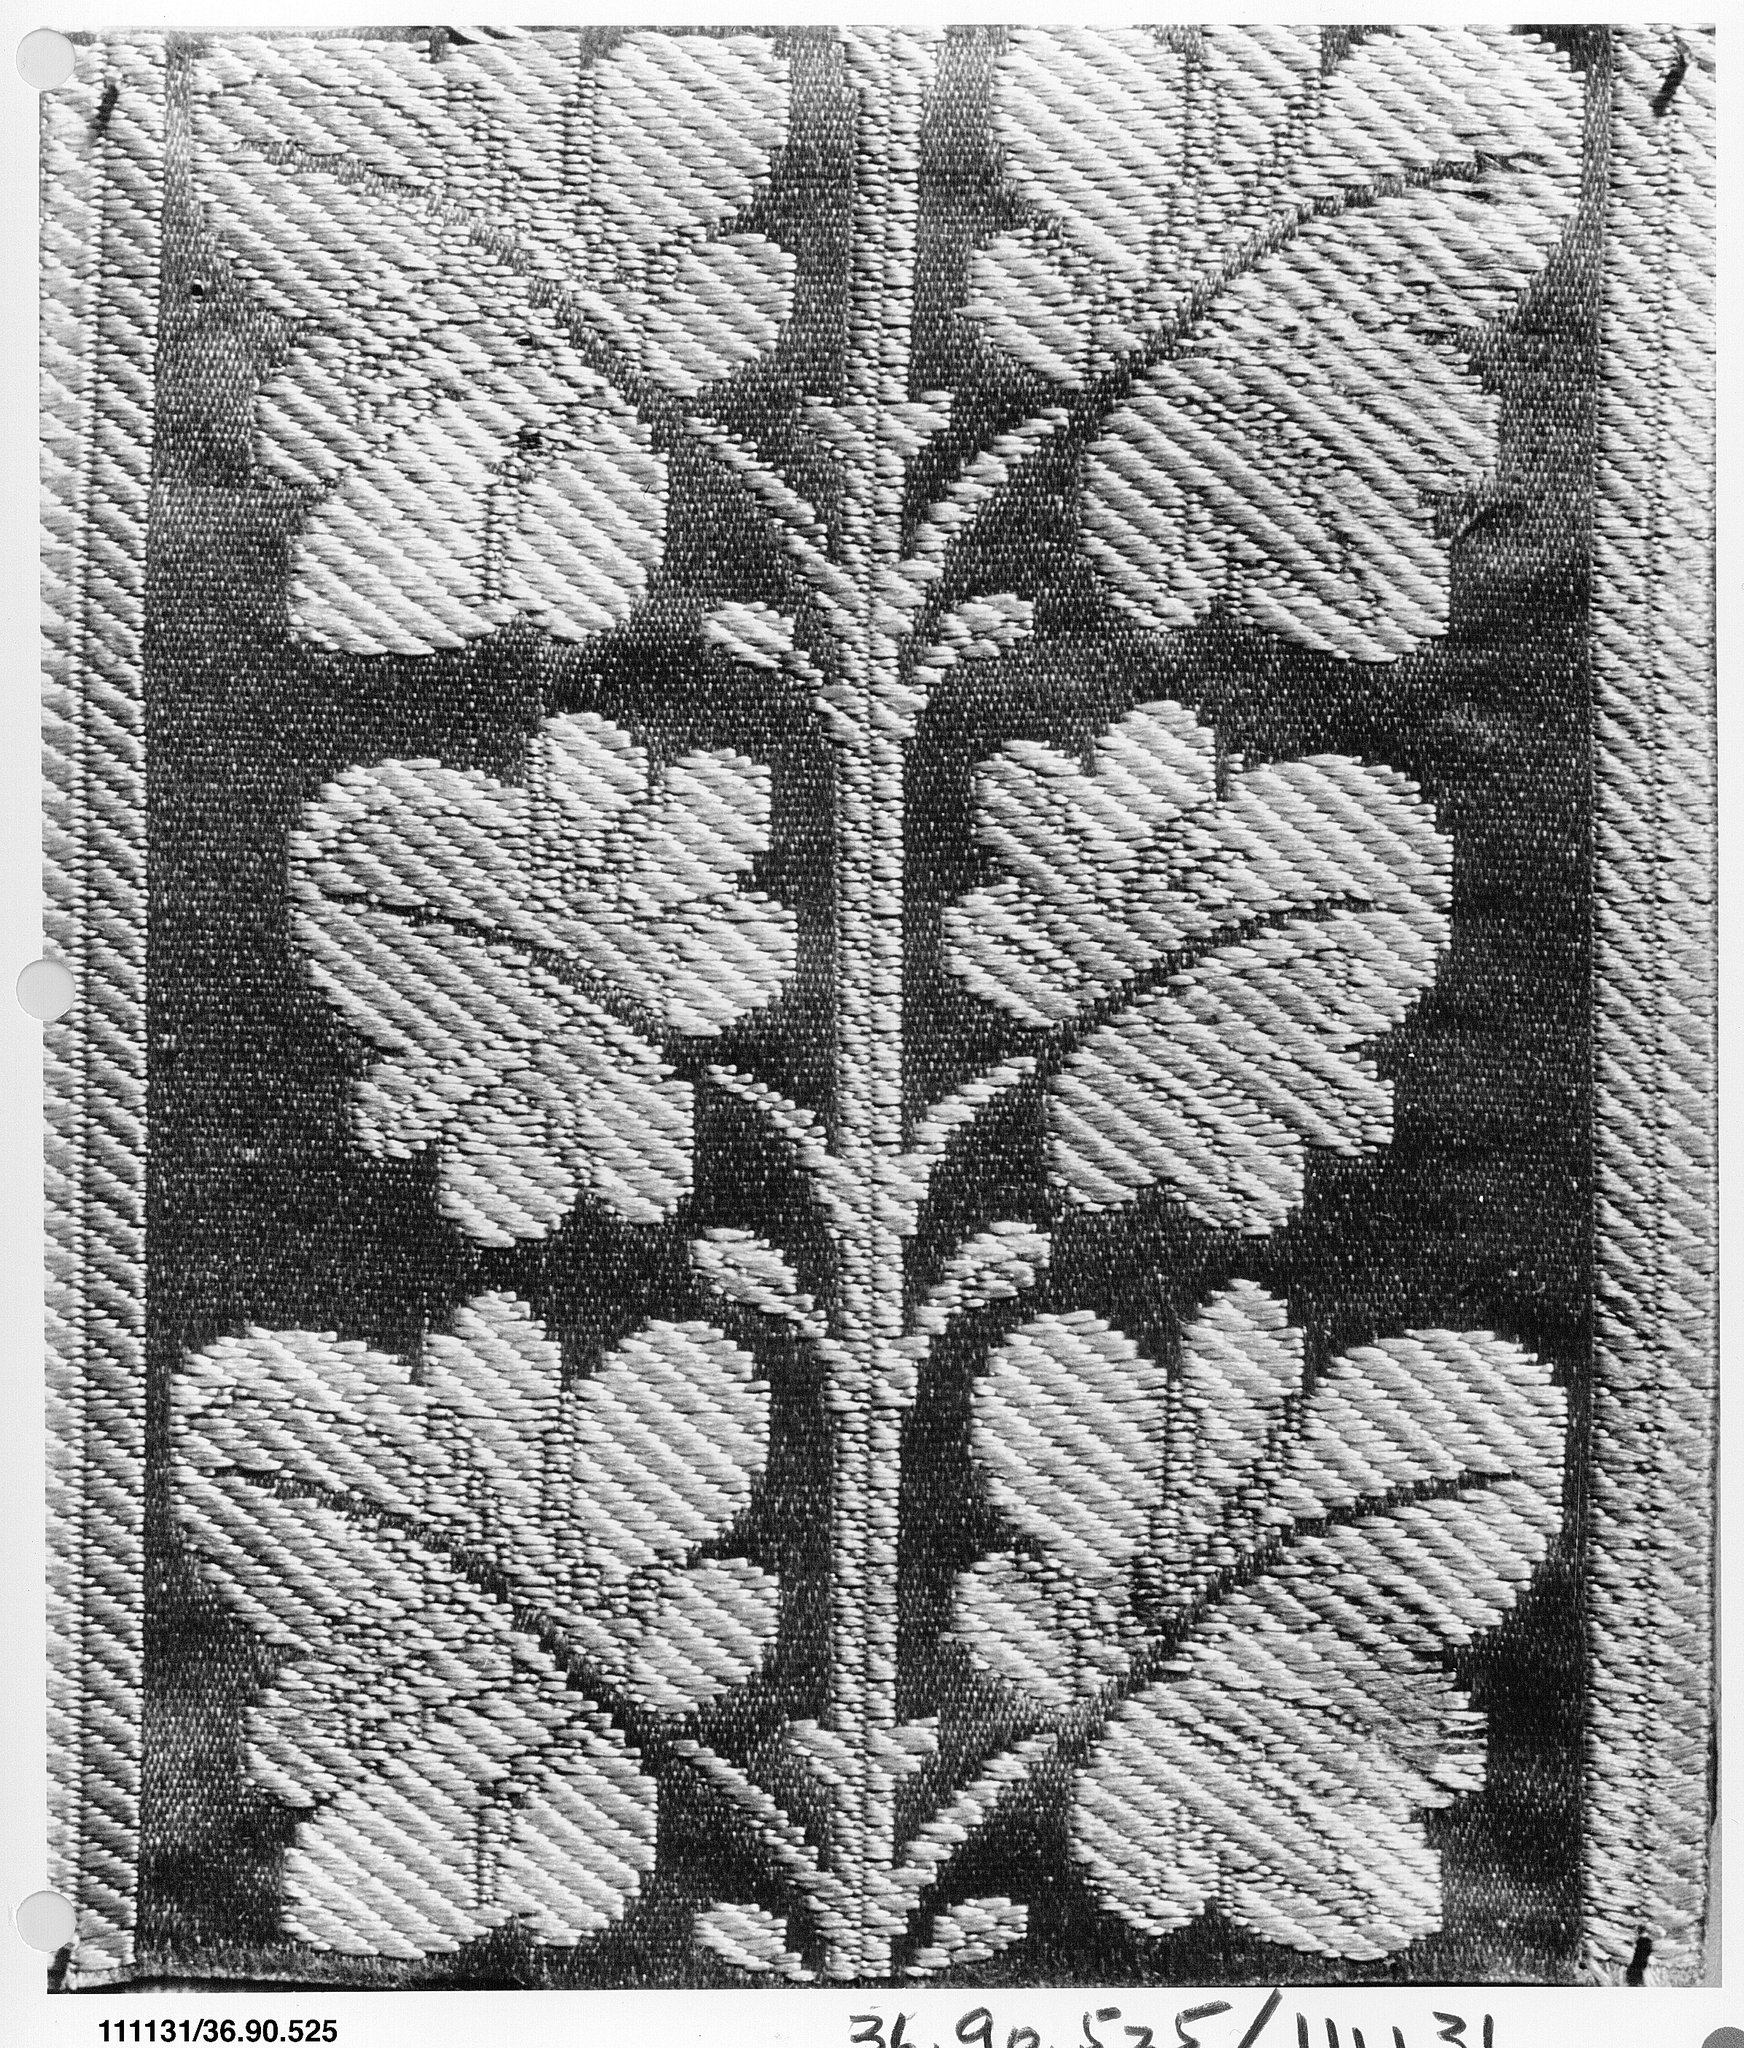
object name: piece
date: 1801-1833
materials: silk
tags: leaves